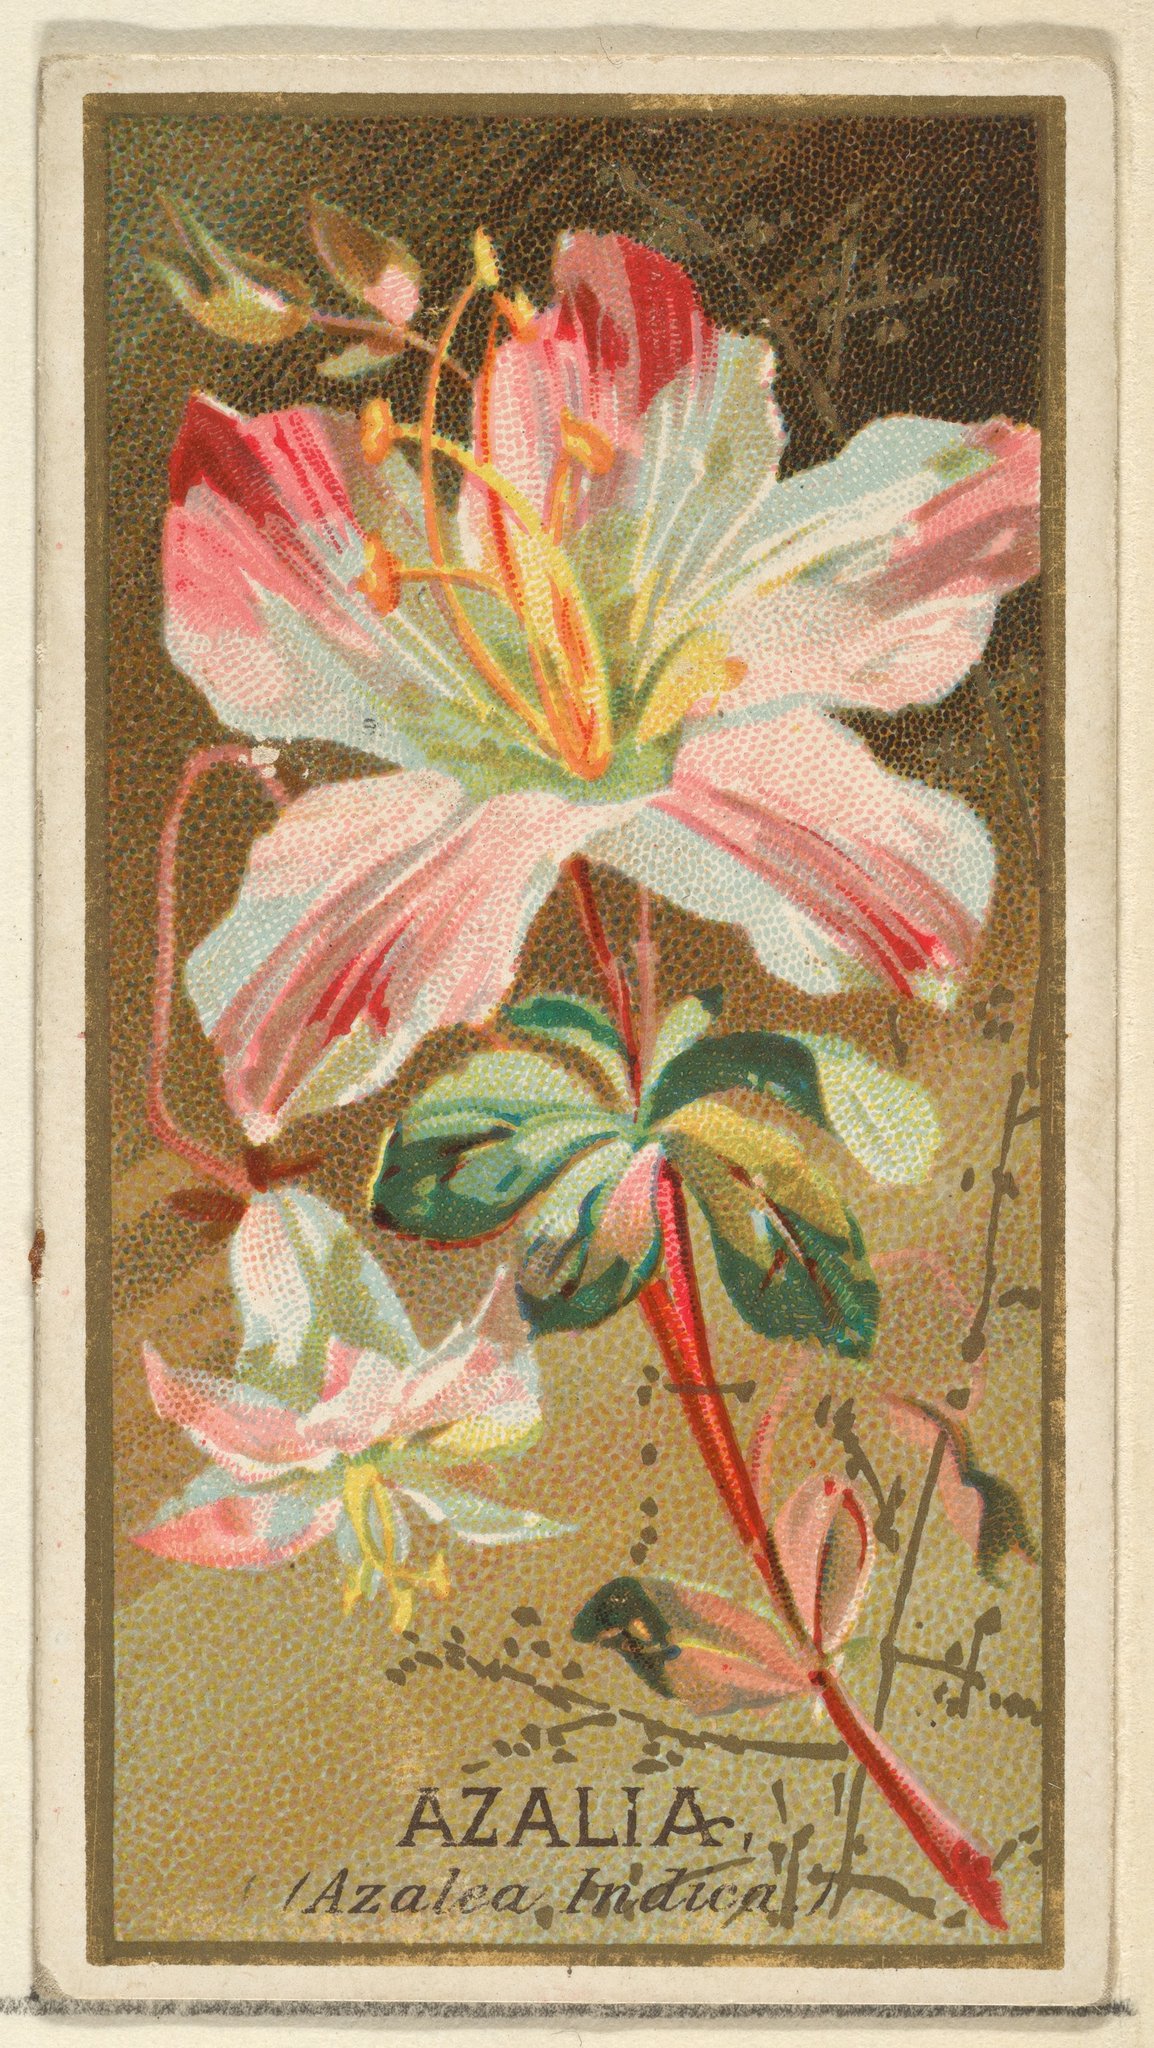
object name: print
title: Azalia (Azalea Indica), from the Flowers series for Old Judge Cigarettes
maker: goodwin & company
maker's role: publisher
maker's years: 1850-1950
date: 1890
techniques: color lithograph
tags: flowers